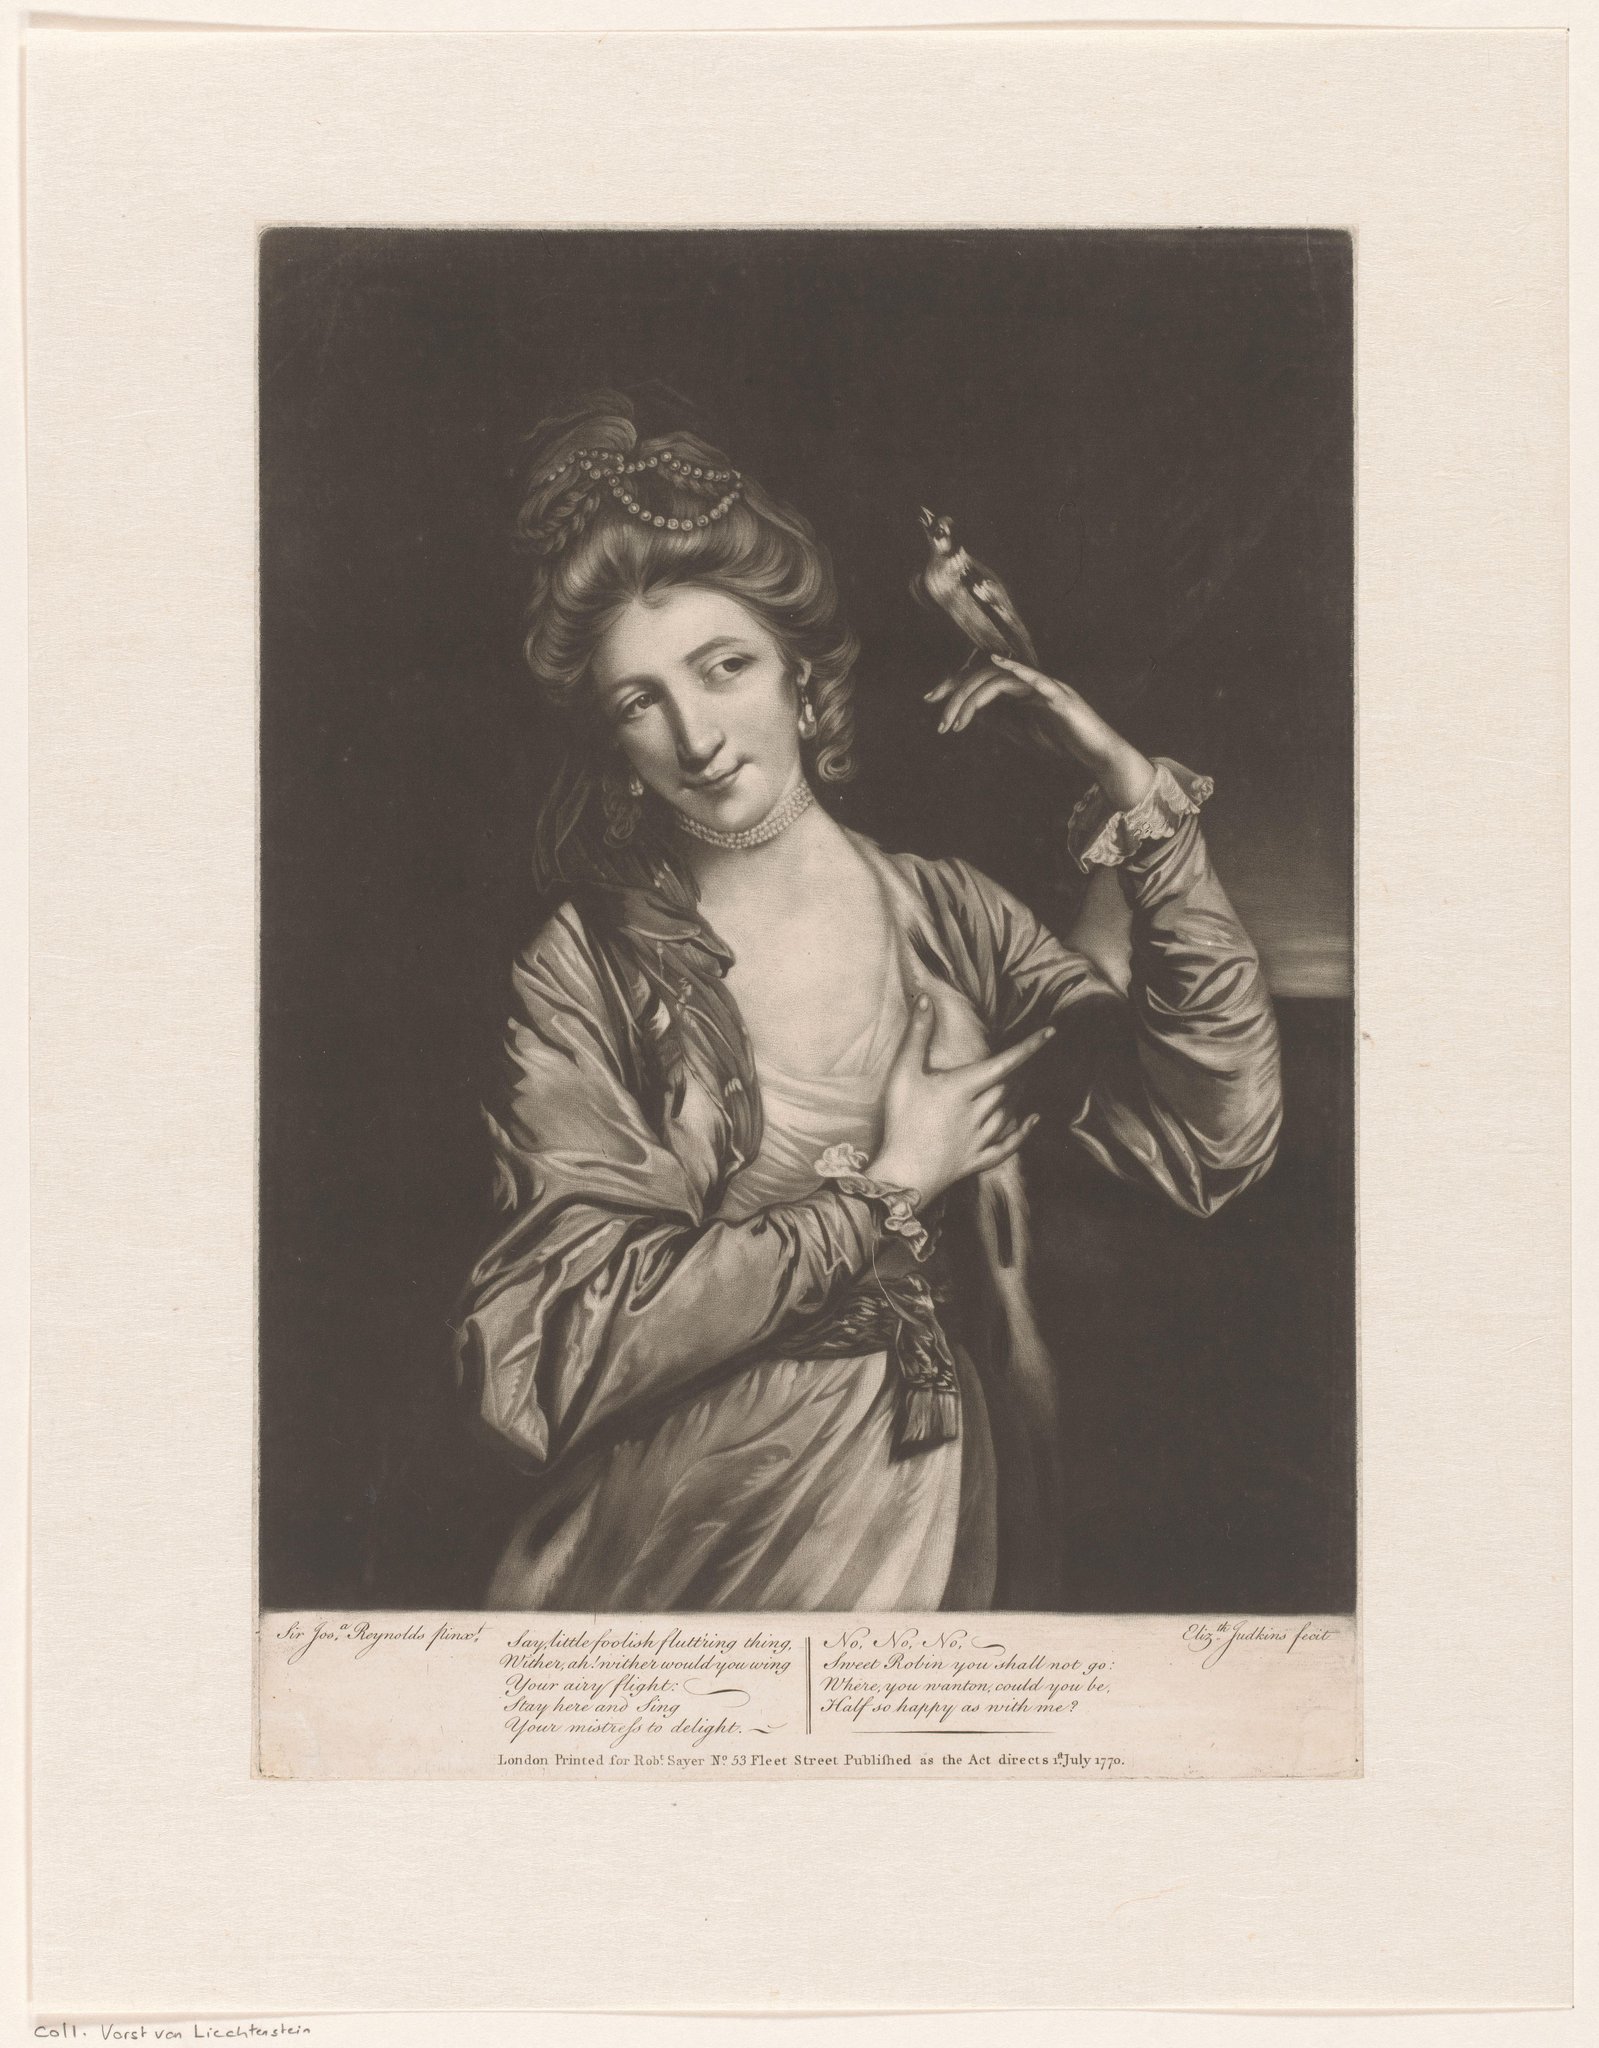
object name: print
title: Portret van Harriet Powell met een zangvogel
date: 1770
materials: paper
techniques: etching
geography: london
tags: historical persons, portrait of actor, actress, portrait of opera-singer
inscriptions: collector's mark: Lugt 2760, collector's mark: Lugt 2228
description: Tekst in het Engels in de ondermarge. Harriet in de rol van 'Leonora' uit de opera 'The Padlock' door Charles Dibdin.